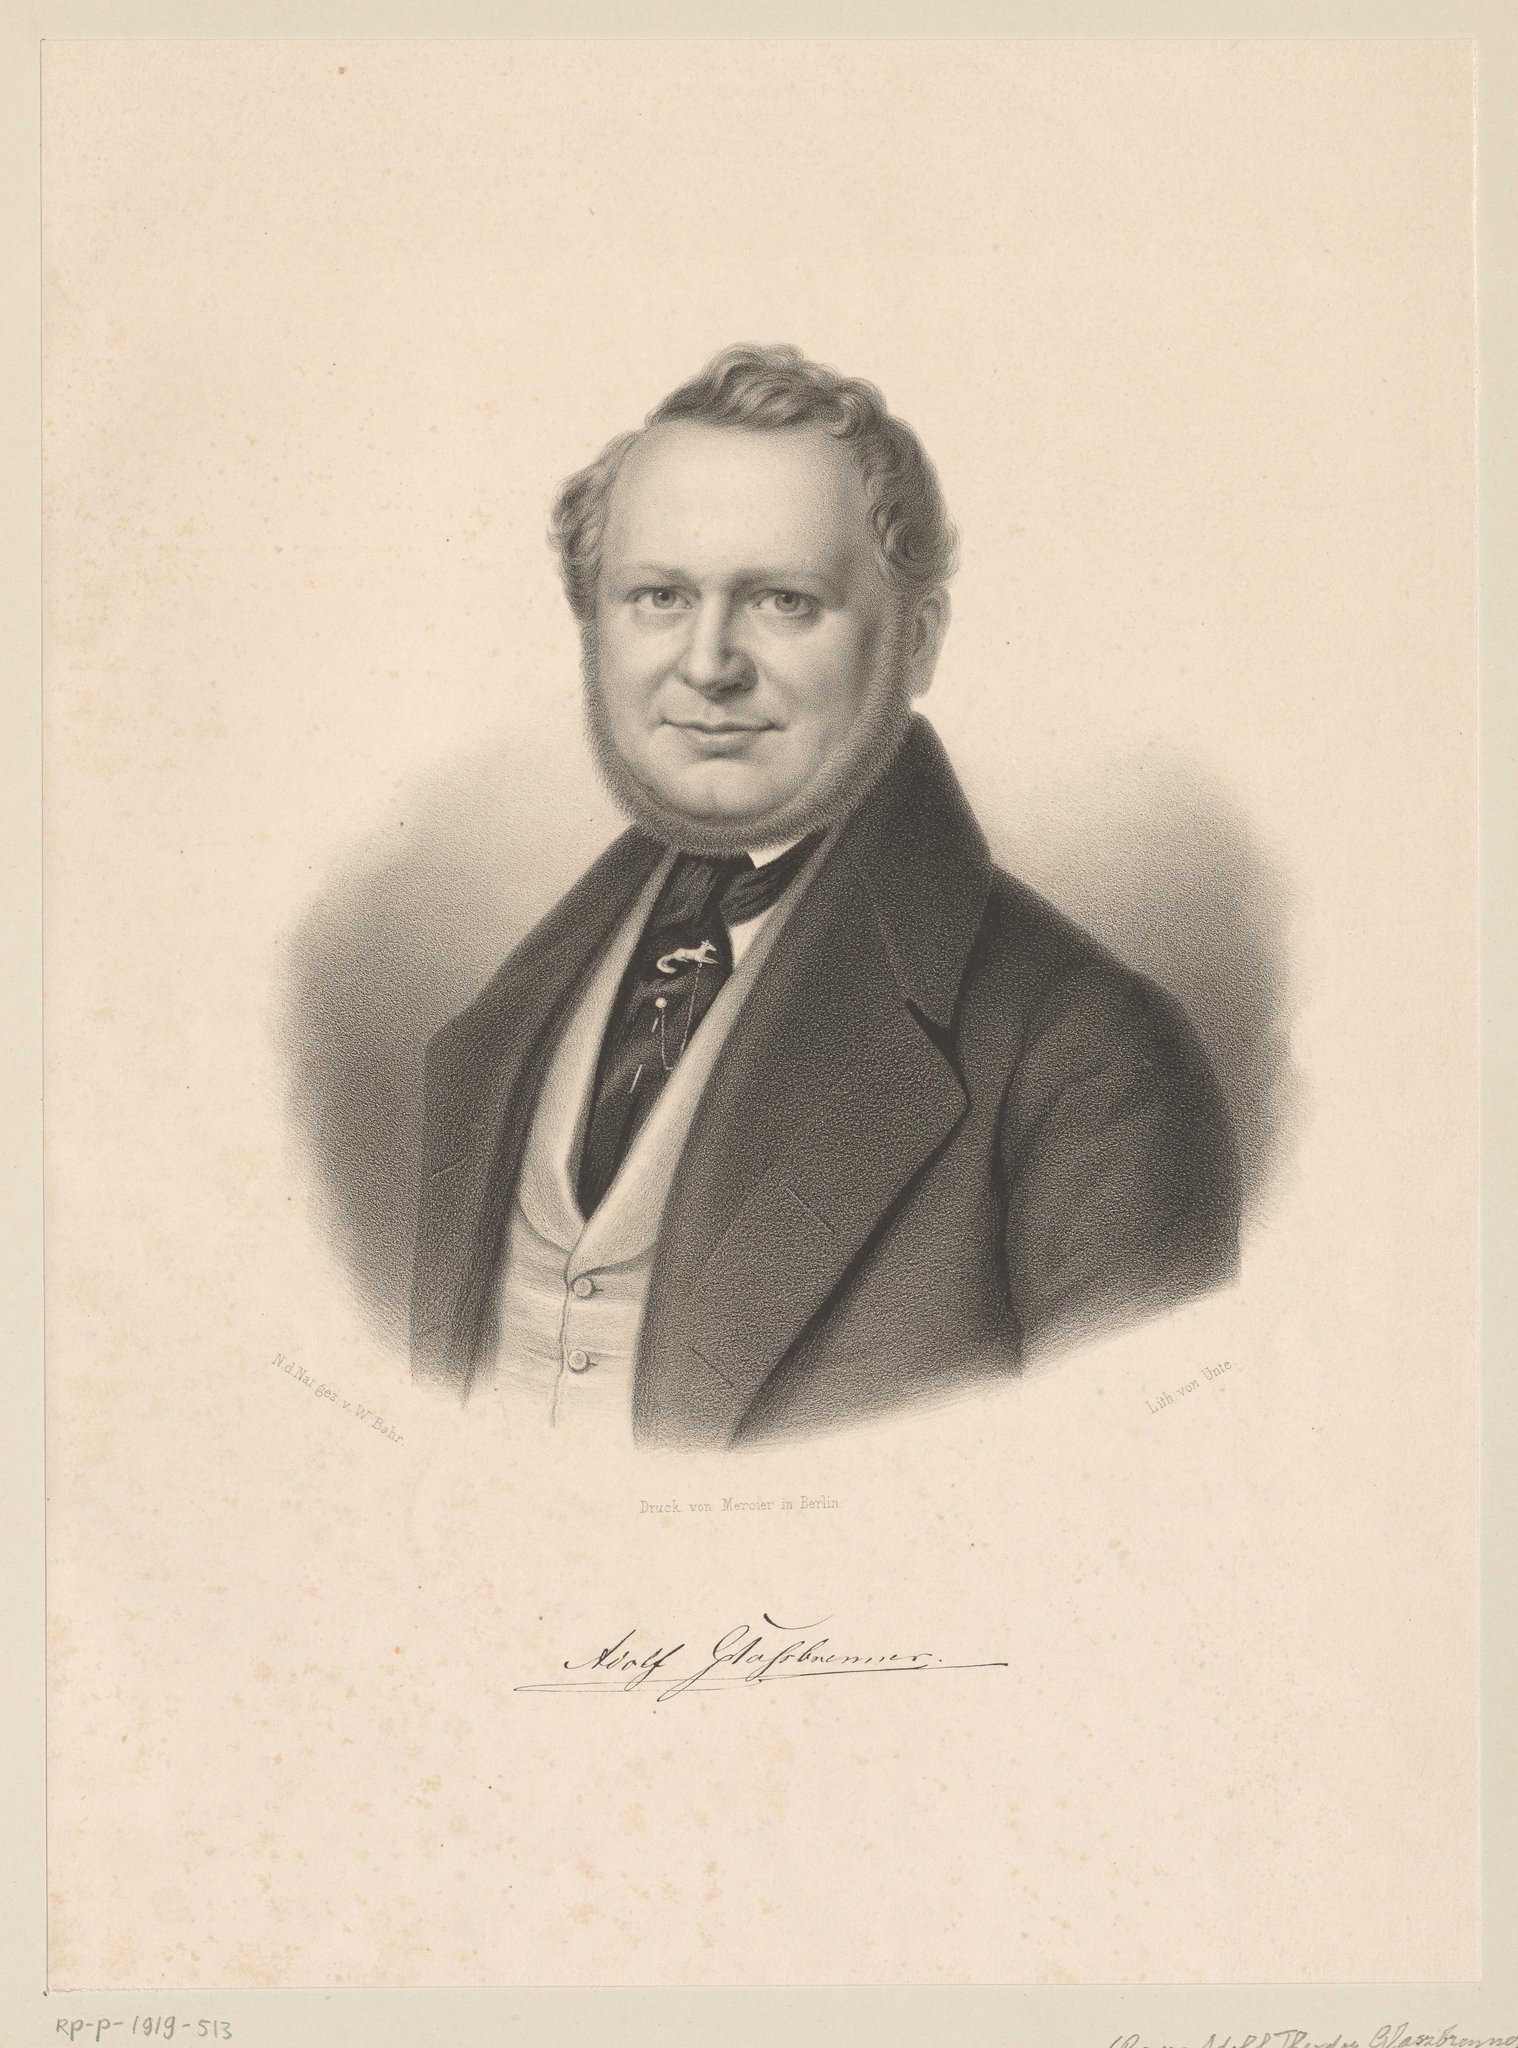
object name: print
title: Portret van Adolf Glassbrenner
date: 1845-1900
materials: paper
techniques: lithograph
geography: berlin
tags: berlin, journalist, reporter, historical persons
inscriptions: collector's mark: Lugt 2228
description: Een facsimile signatuur in de ondermarge.